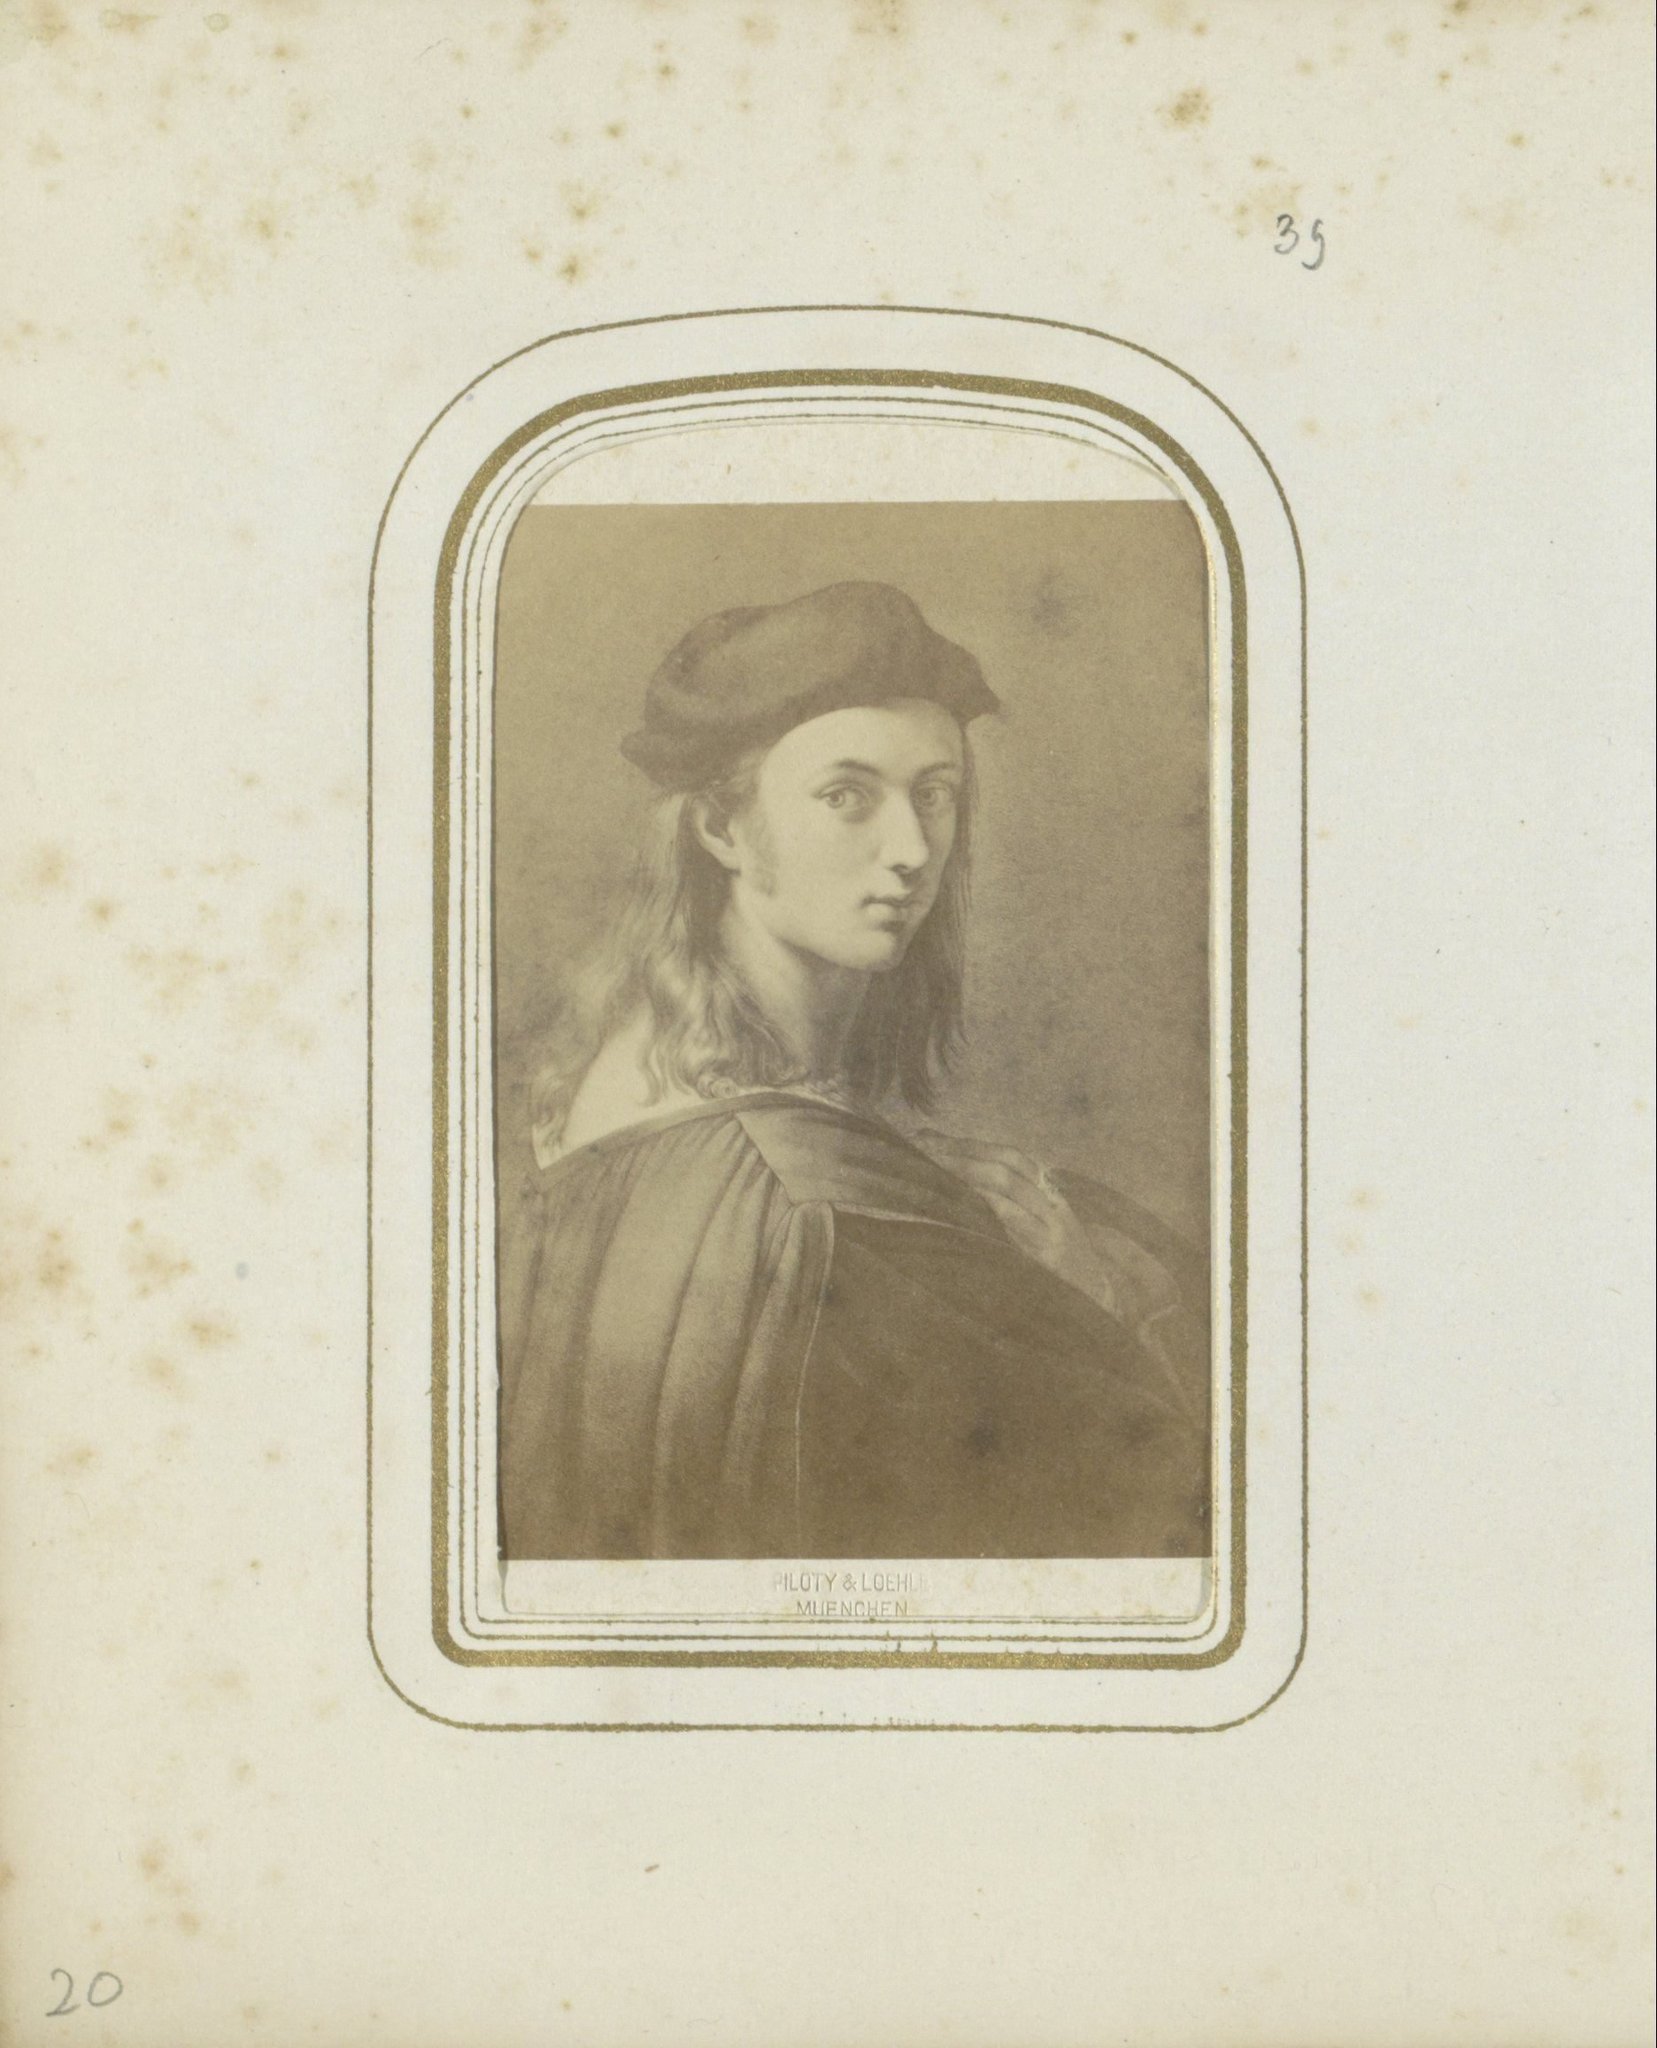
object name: reproduction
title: Fotoreproductie van een lithografie naar een schilderij door Rafaël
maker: Anonymous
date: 1865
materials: paper, photographic support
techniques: albumen print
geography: germany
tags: youth, adolescent, travelling; tourism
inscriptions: check stamp: ‘Piloty&Loehe Muenchen’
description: Foto is een opname van een lithografie door A. Lutz, naar een geschilderd portret van Bindo Altoviti door Rafaël. Lithografie gepubliceerd in: Alte Pinakothek, 'Königl. Bayer. Pinakothek zu München und Gemälde-Gallerie zu Schleissheim. Mit seiner Majestät des Königs von Bayern allerhöchster Genehmigung in lithographierten Abbildungen, herausgegeben in der Kunst-Anstalt von Piloty & Loehle in München', uitgegeven 1837-42.